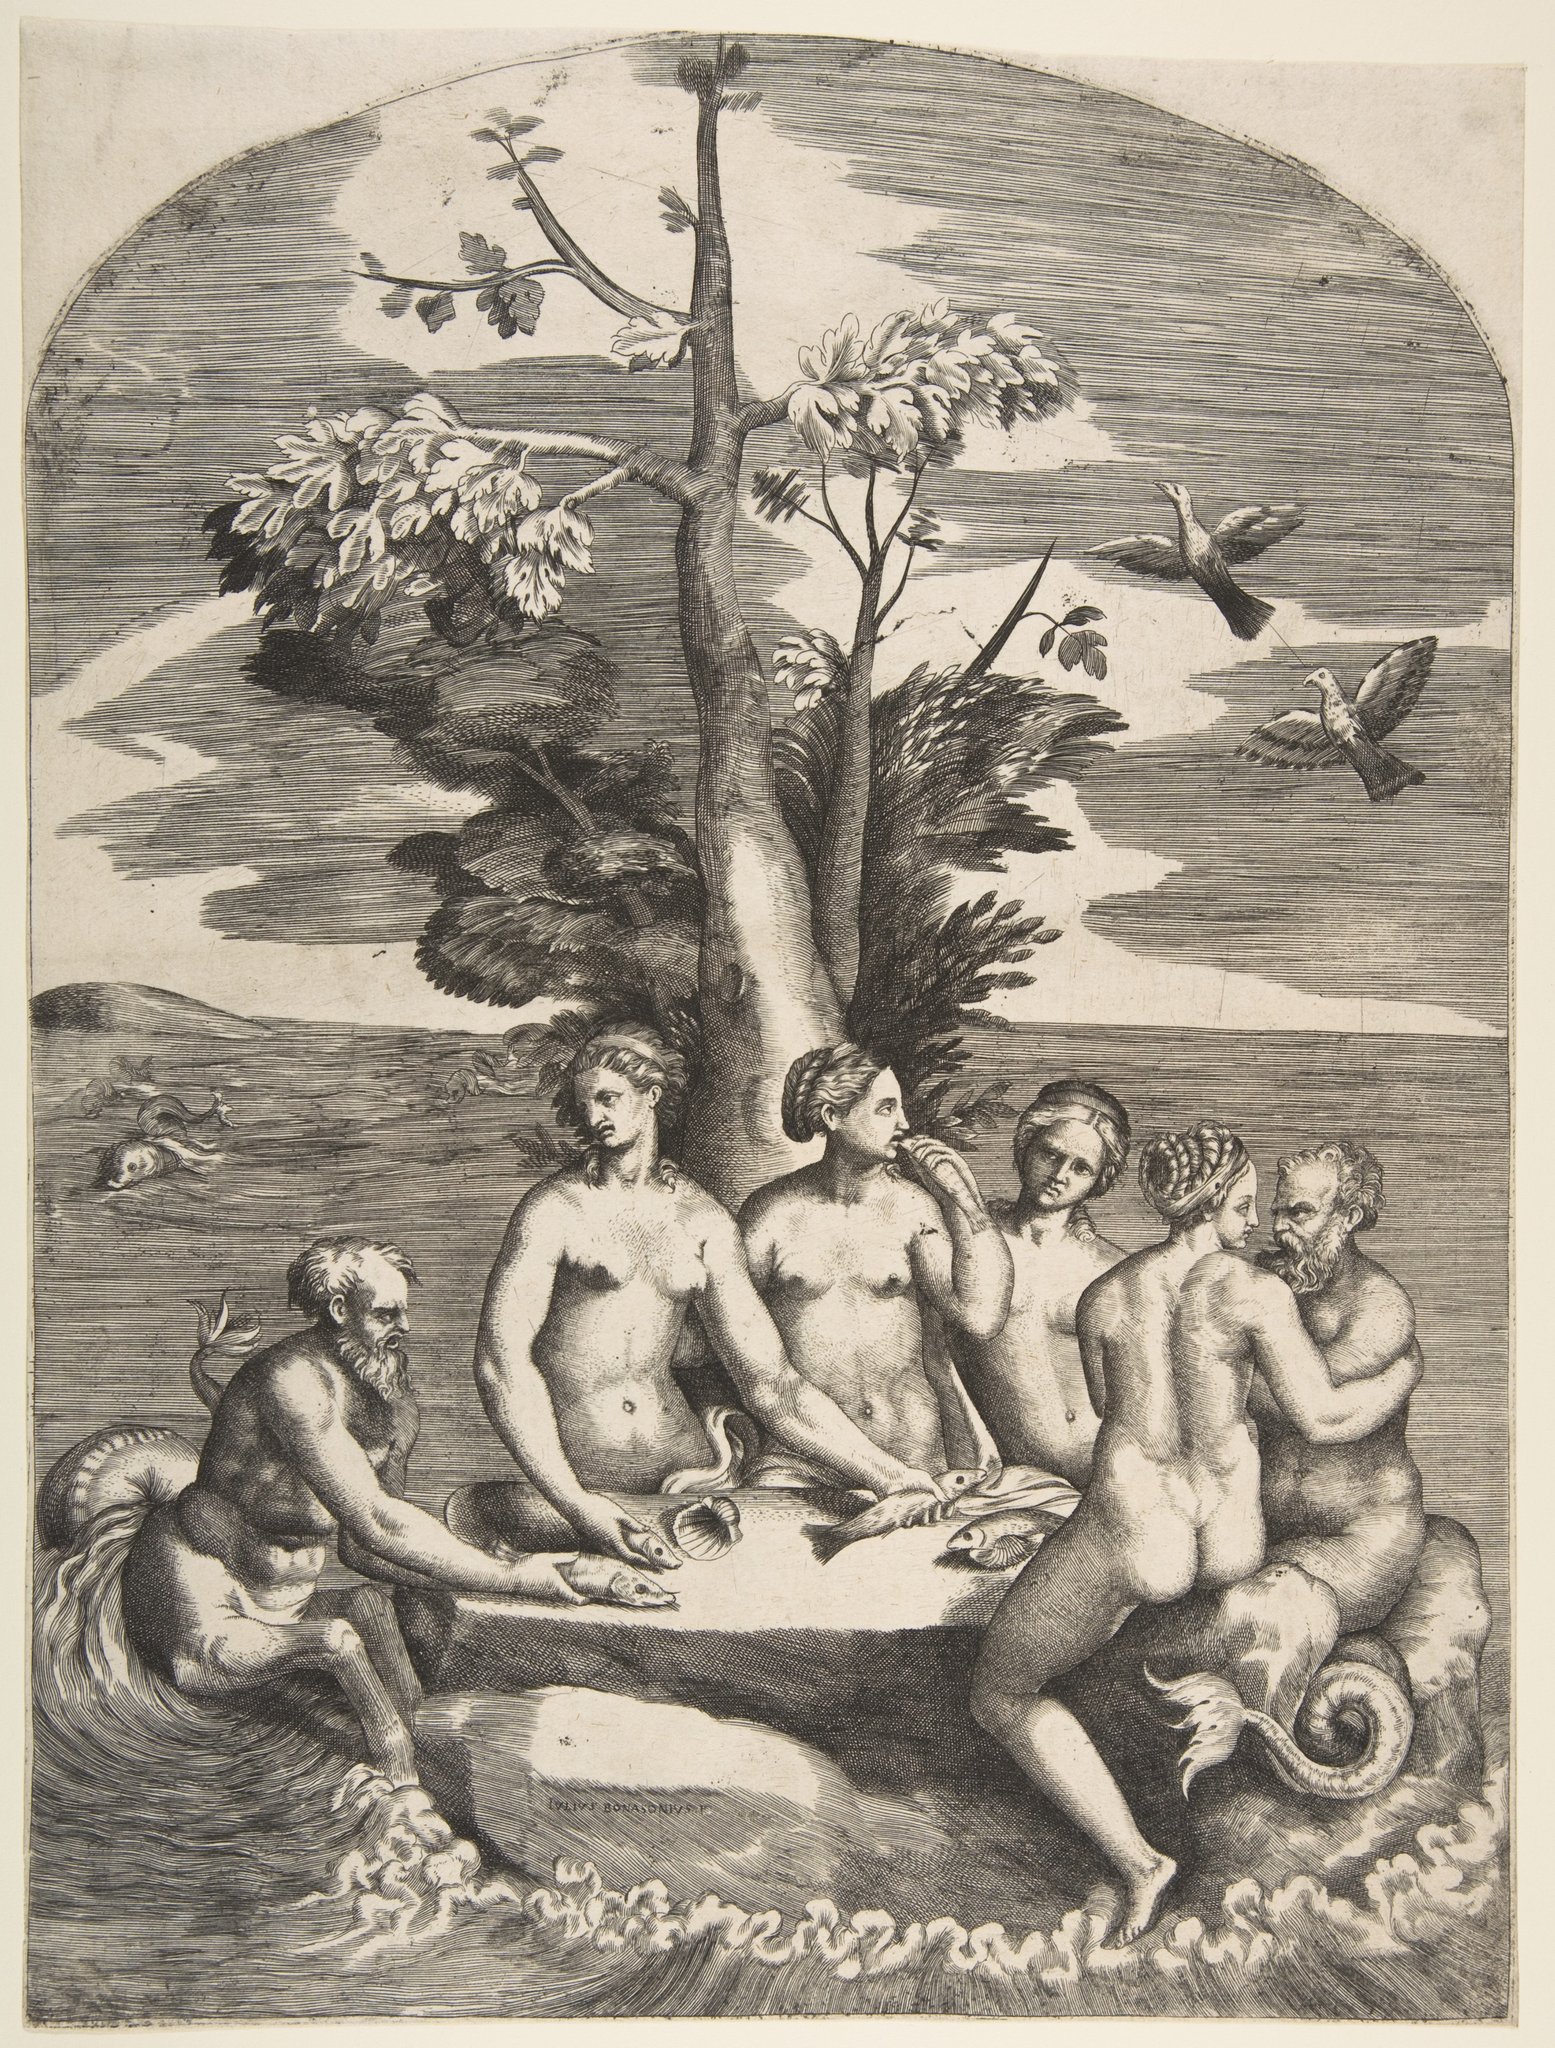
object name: print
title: Two sea gods accompanied by four nymphs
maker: giulio bonasone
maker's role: artist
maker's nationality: italian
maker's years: 1510-1576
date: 1531-1576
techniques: engraving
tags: birds,mythical creatures,nymphs,fish